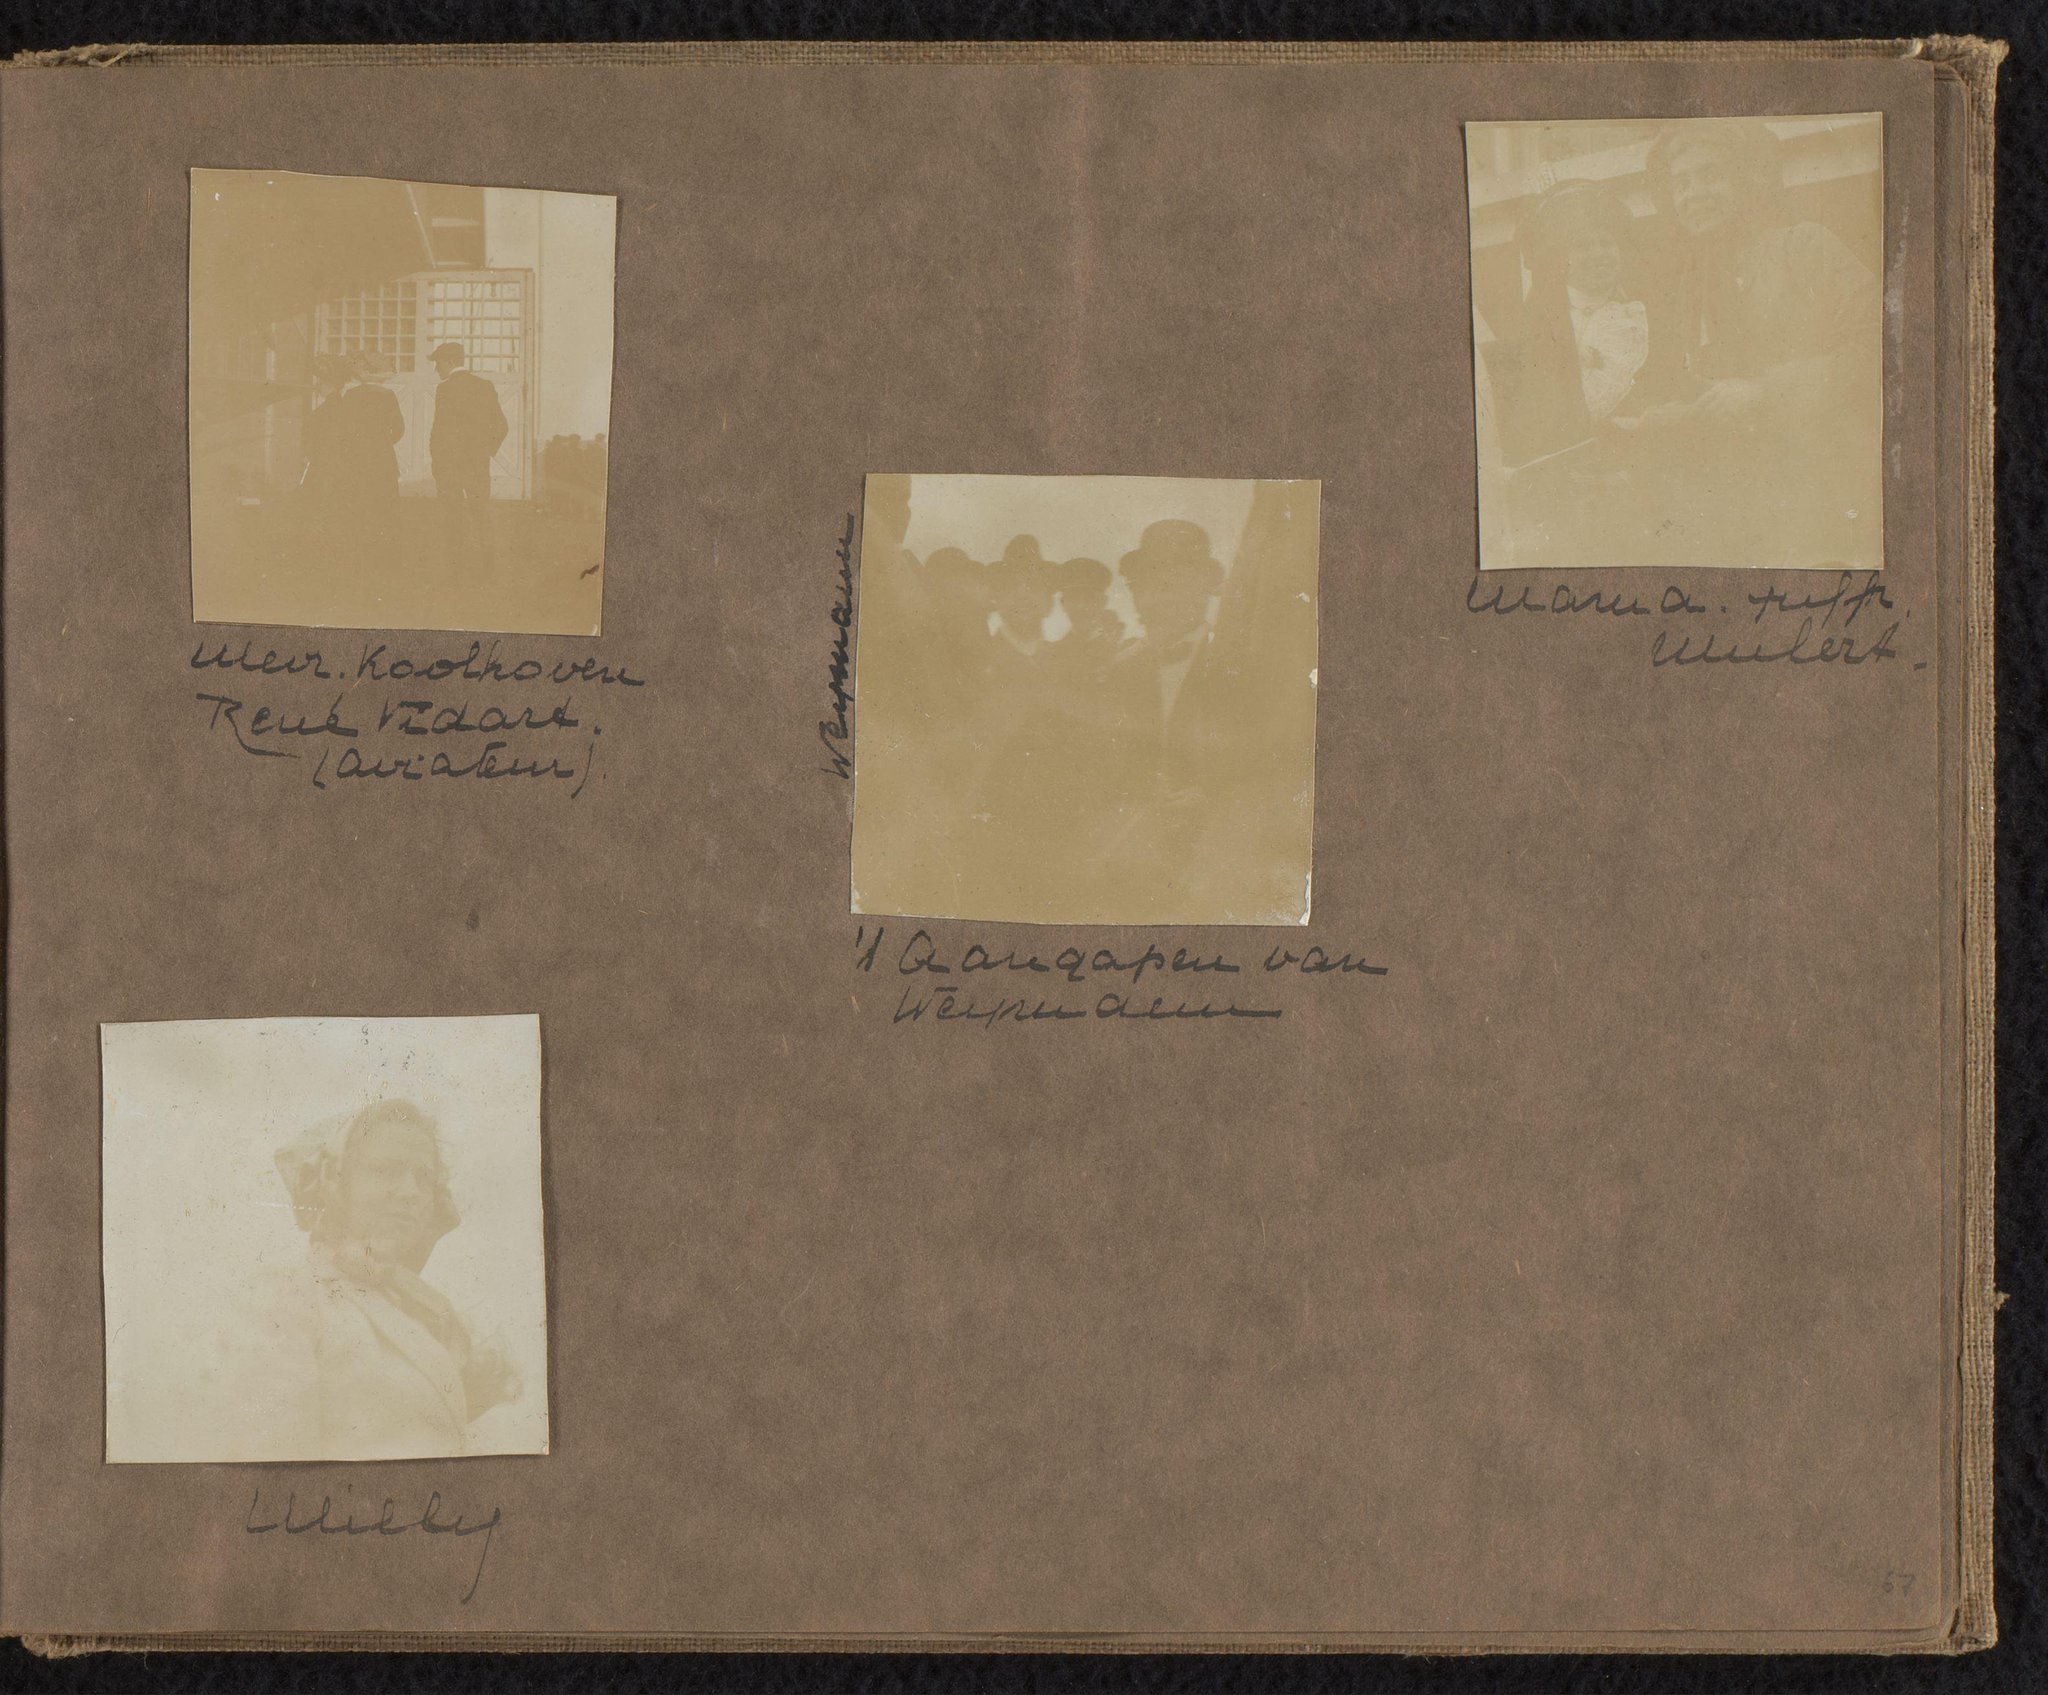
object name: album leaf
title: Vijf foto's van de Europese Rondvlucht te Soesterberg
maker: carolina frederika onnen (lien/loen)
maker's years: 1896-1983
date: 1911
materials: paper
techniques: gelatin silver print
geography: soesterberg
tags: batavia, emilie albertine onnen-van den berg, activities in the air ~ public festivities, e.g. fly-past, pilot, historical persons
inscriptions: inscription: ‘Weynmalen/ 's Aangapen van/ Weynmalen’, inscription: ‘Mama tul jr/ Mulert’, inscription: ‘Willy’, inscription: ‘Mevr. Koolhoven/ René Vidart./ (aviateur)’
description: Deze foto's maken deel uit van een album.